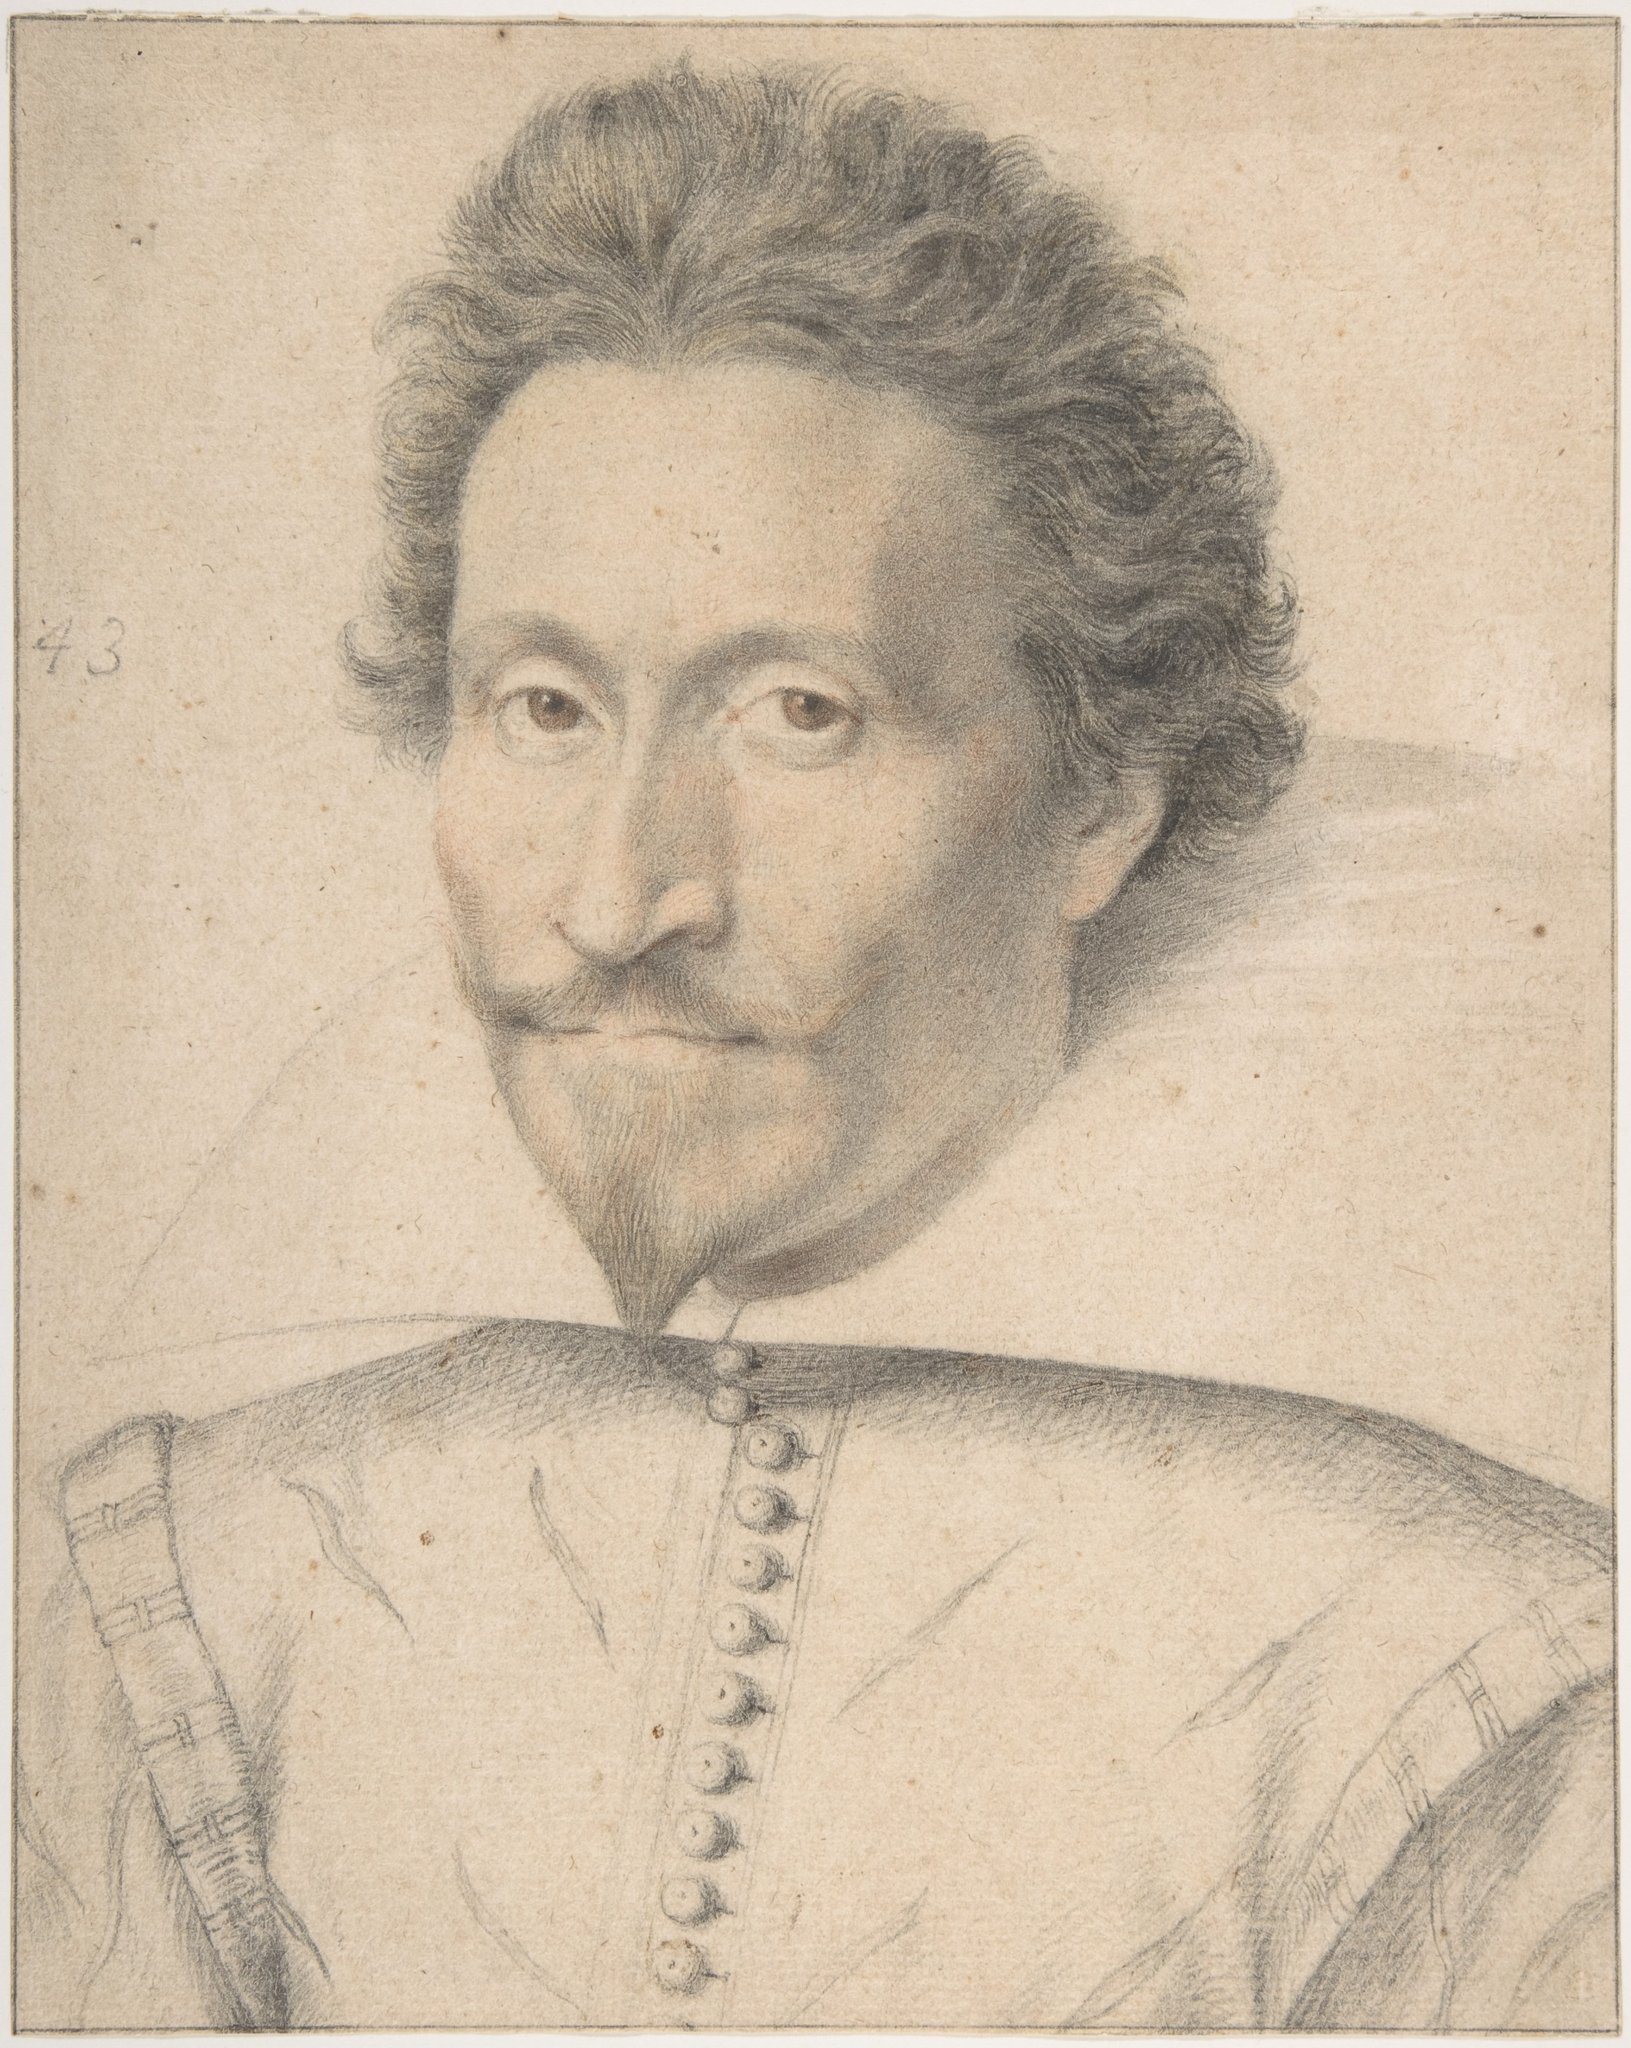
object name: drawing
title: Portrait of a Man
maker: anonymous, french, 16th century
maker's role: artist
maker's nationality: french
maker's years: 1500-1600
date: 1500-1599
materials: chalk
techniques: heightening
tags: men,portraits